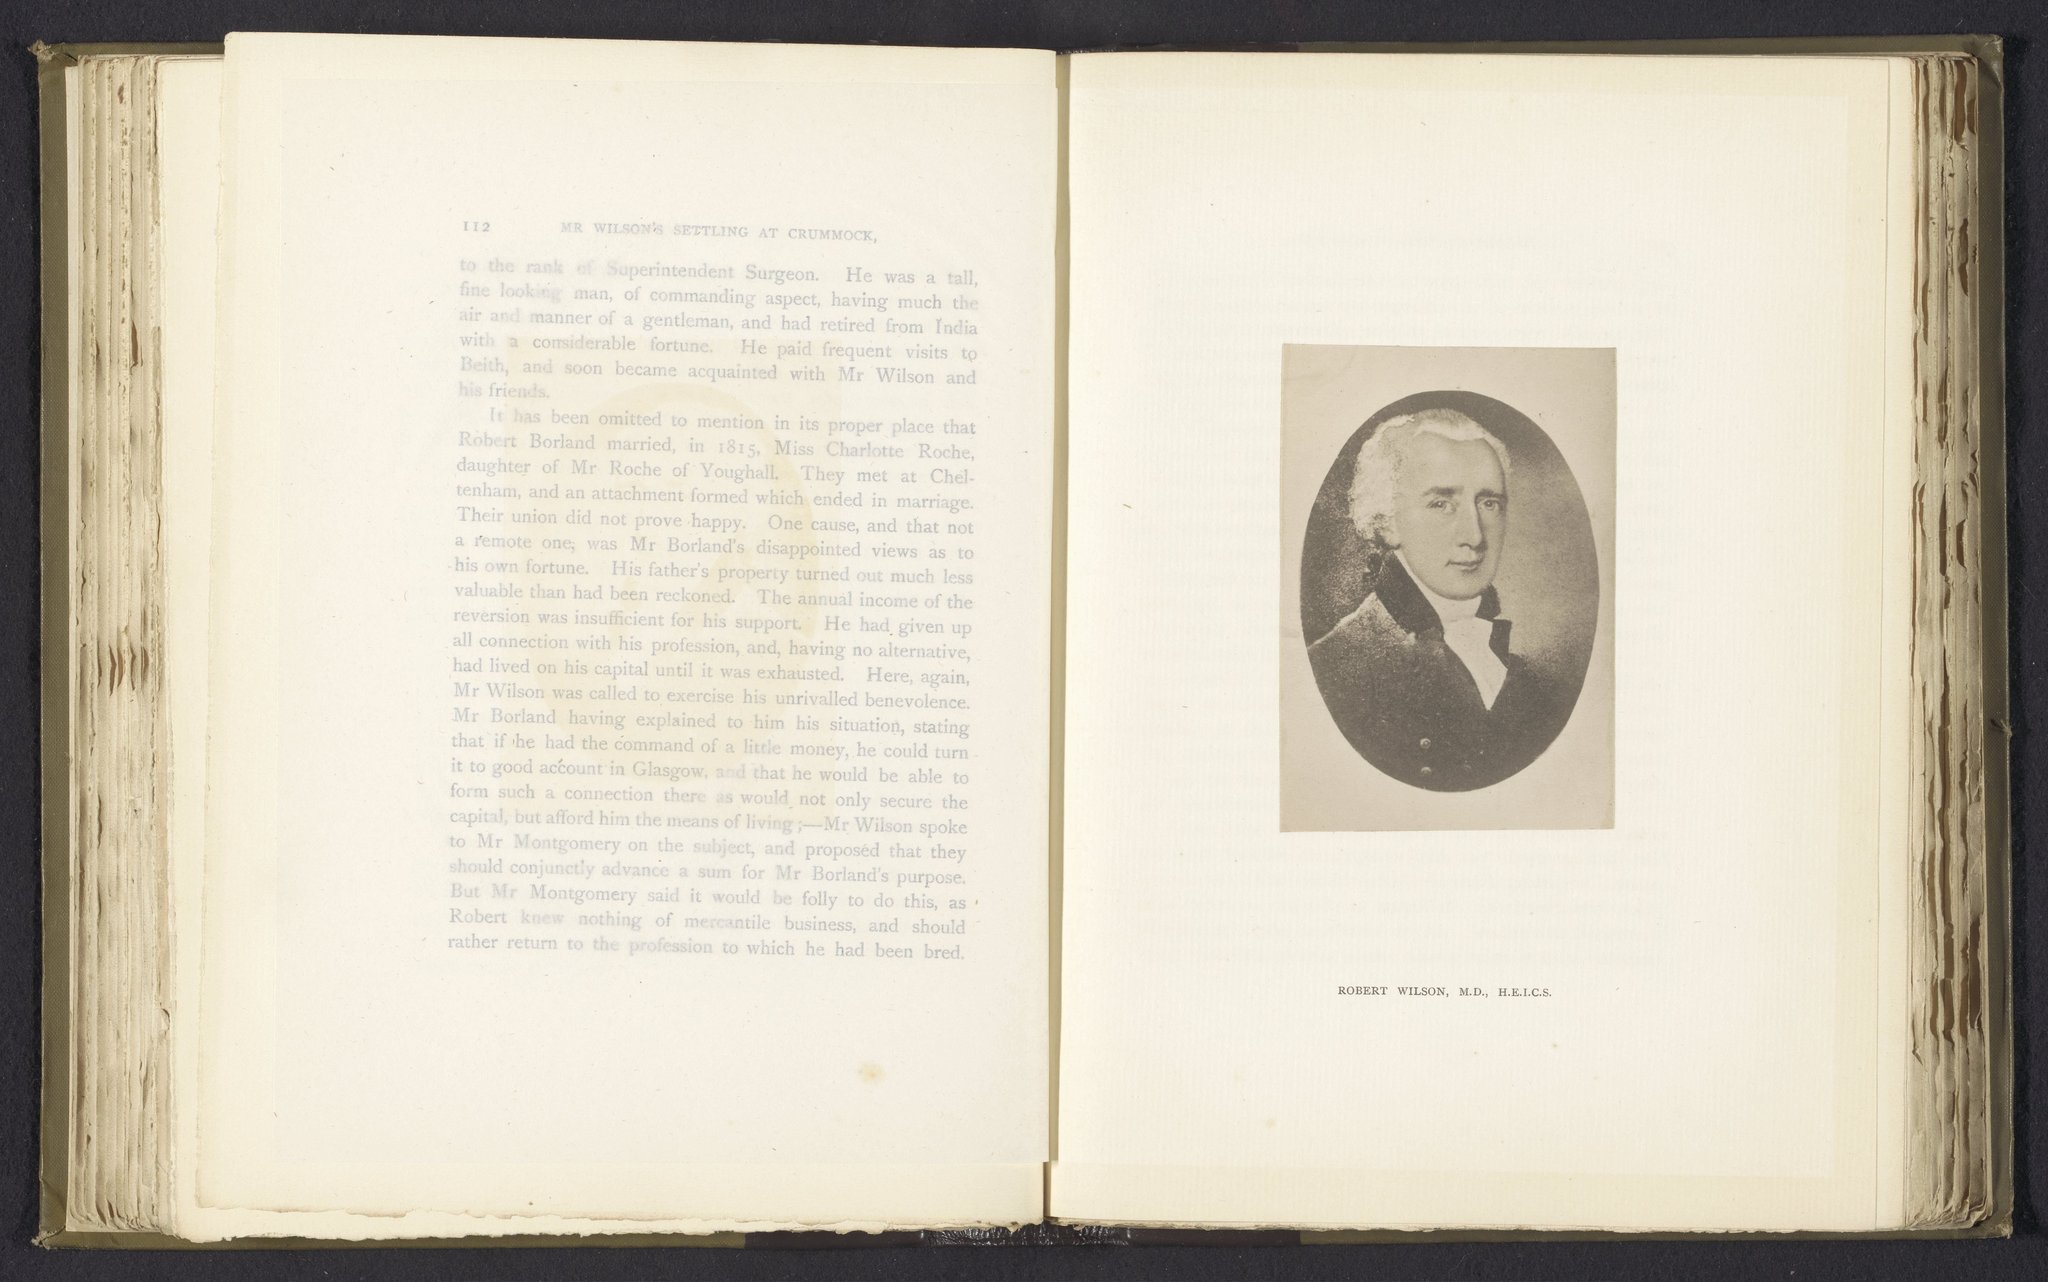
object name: reproduction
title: Robert Wilson, M.D., H.E.I.C.S.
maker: Anonymous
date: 1886-1896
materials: photographic support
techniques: platinum process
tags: historical persons